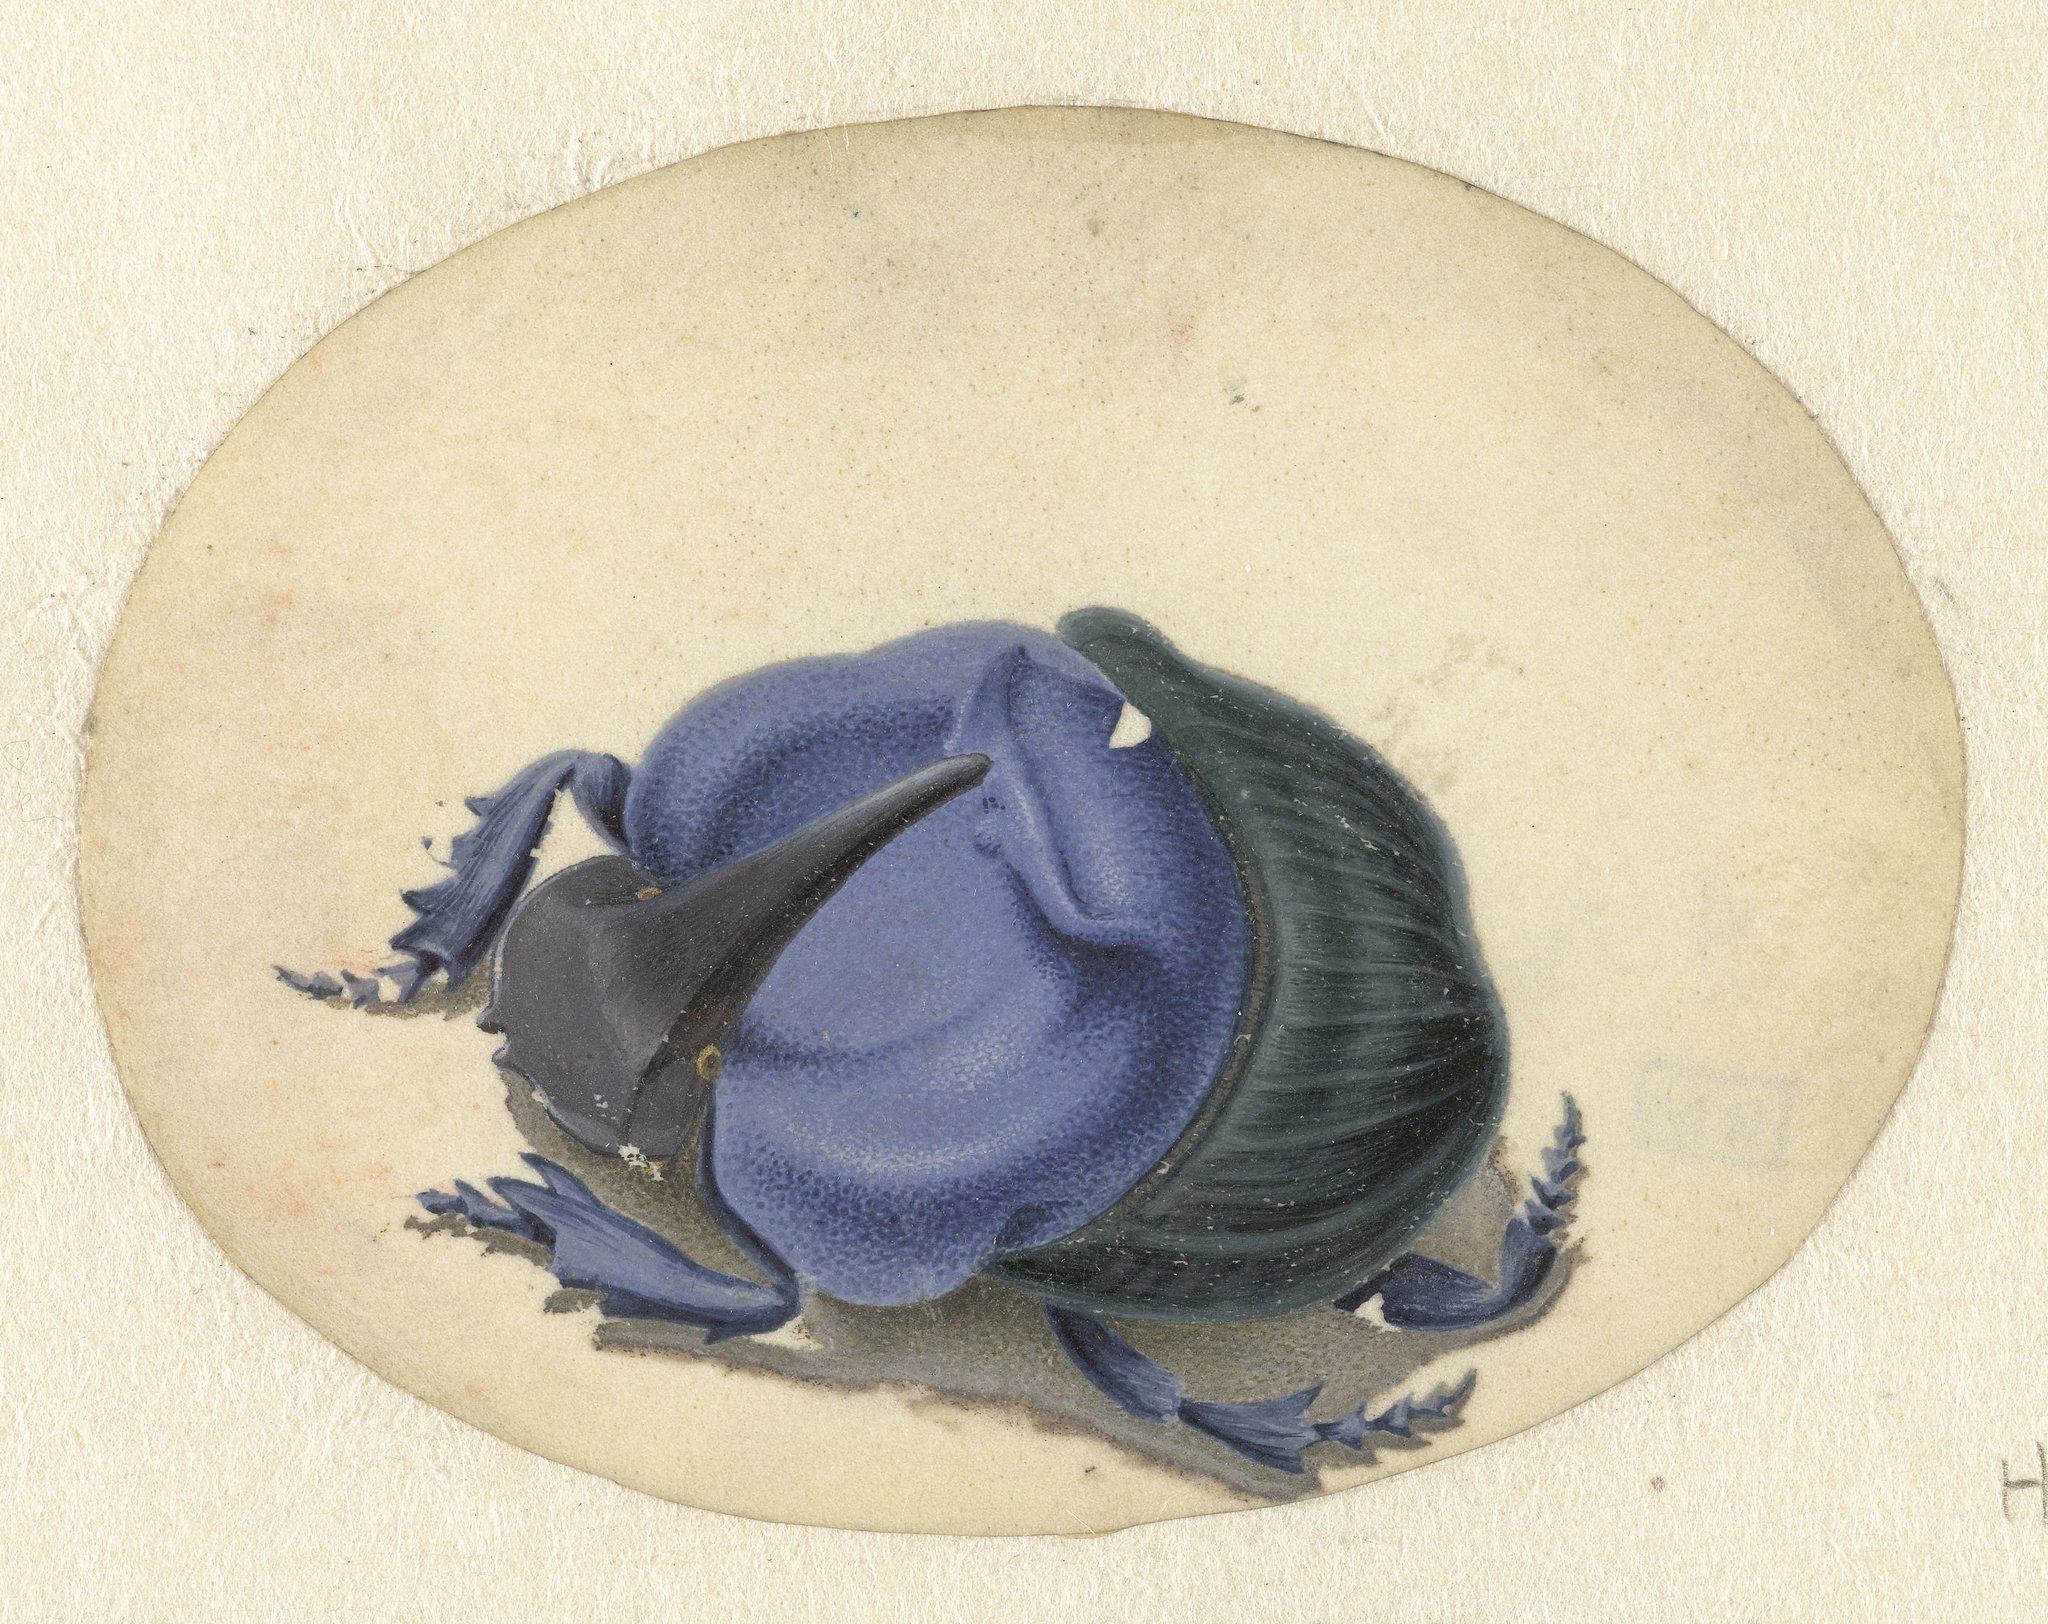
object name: drawing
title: Blauwe kever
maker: jan augustin van der goes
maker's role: draughtsman, painter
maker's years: 1671-1697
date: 1690-1700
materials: paint, gouache, parchment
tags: insects: beetle